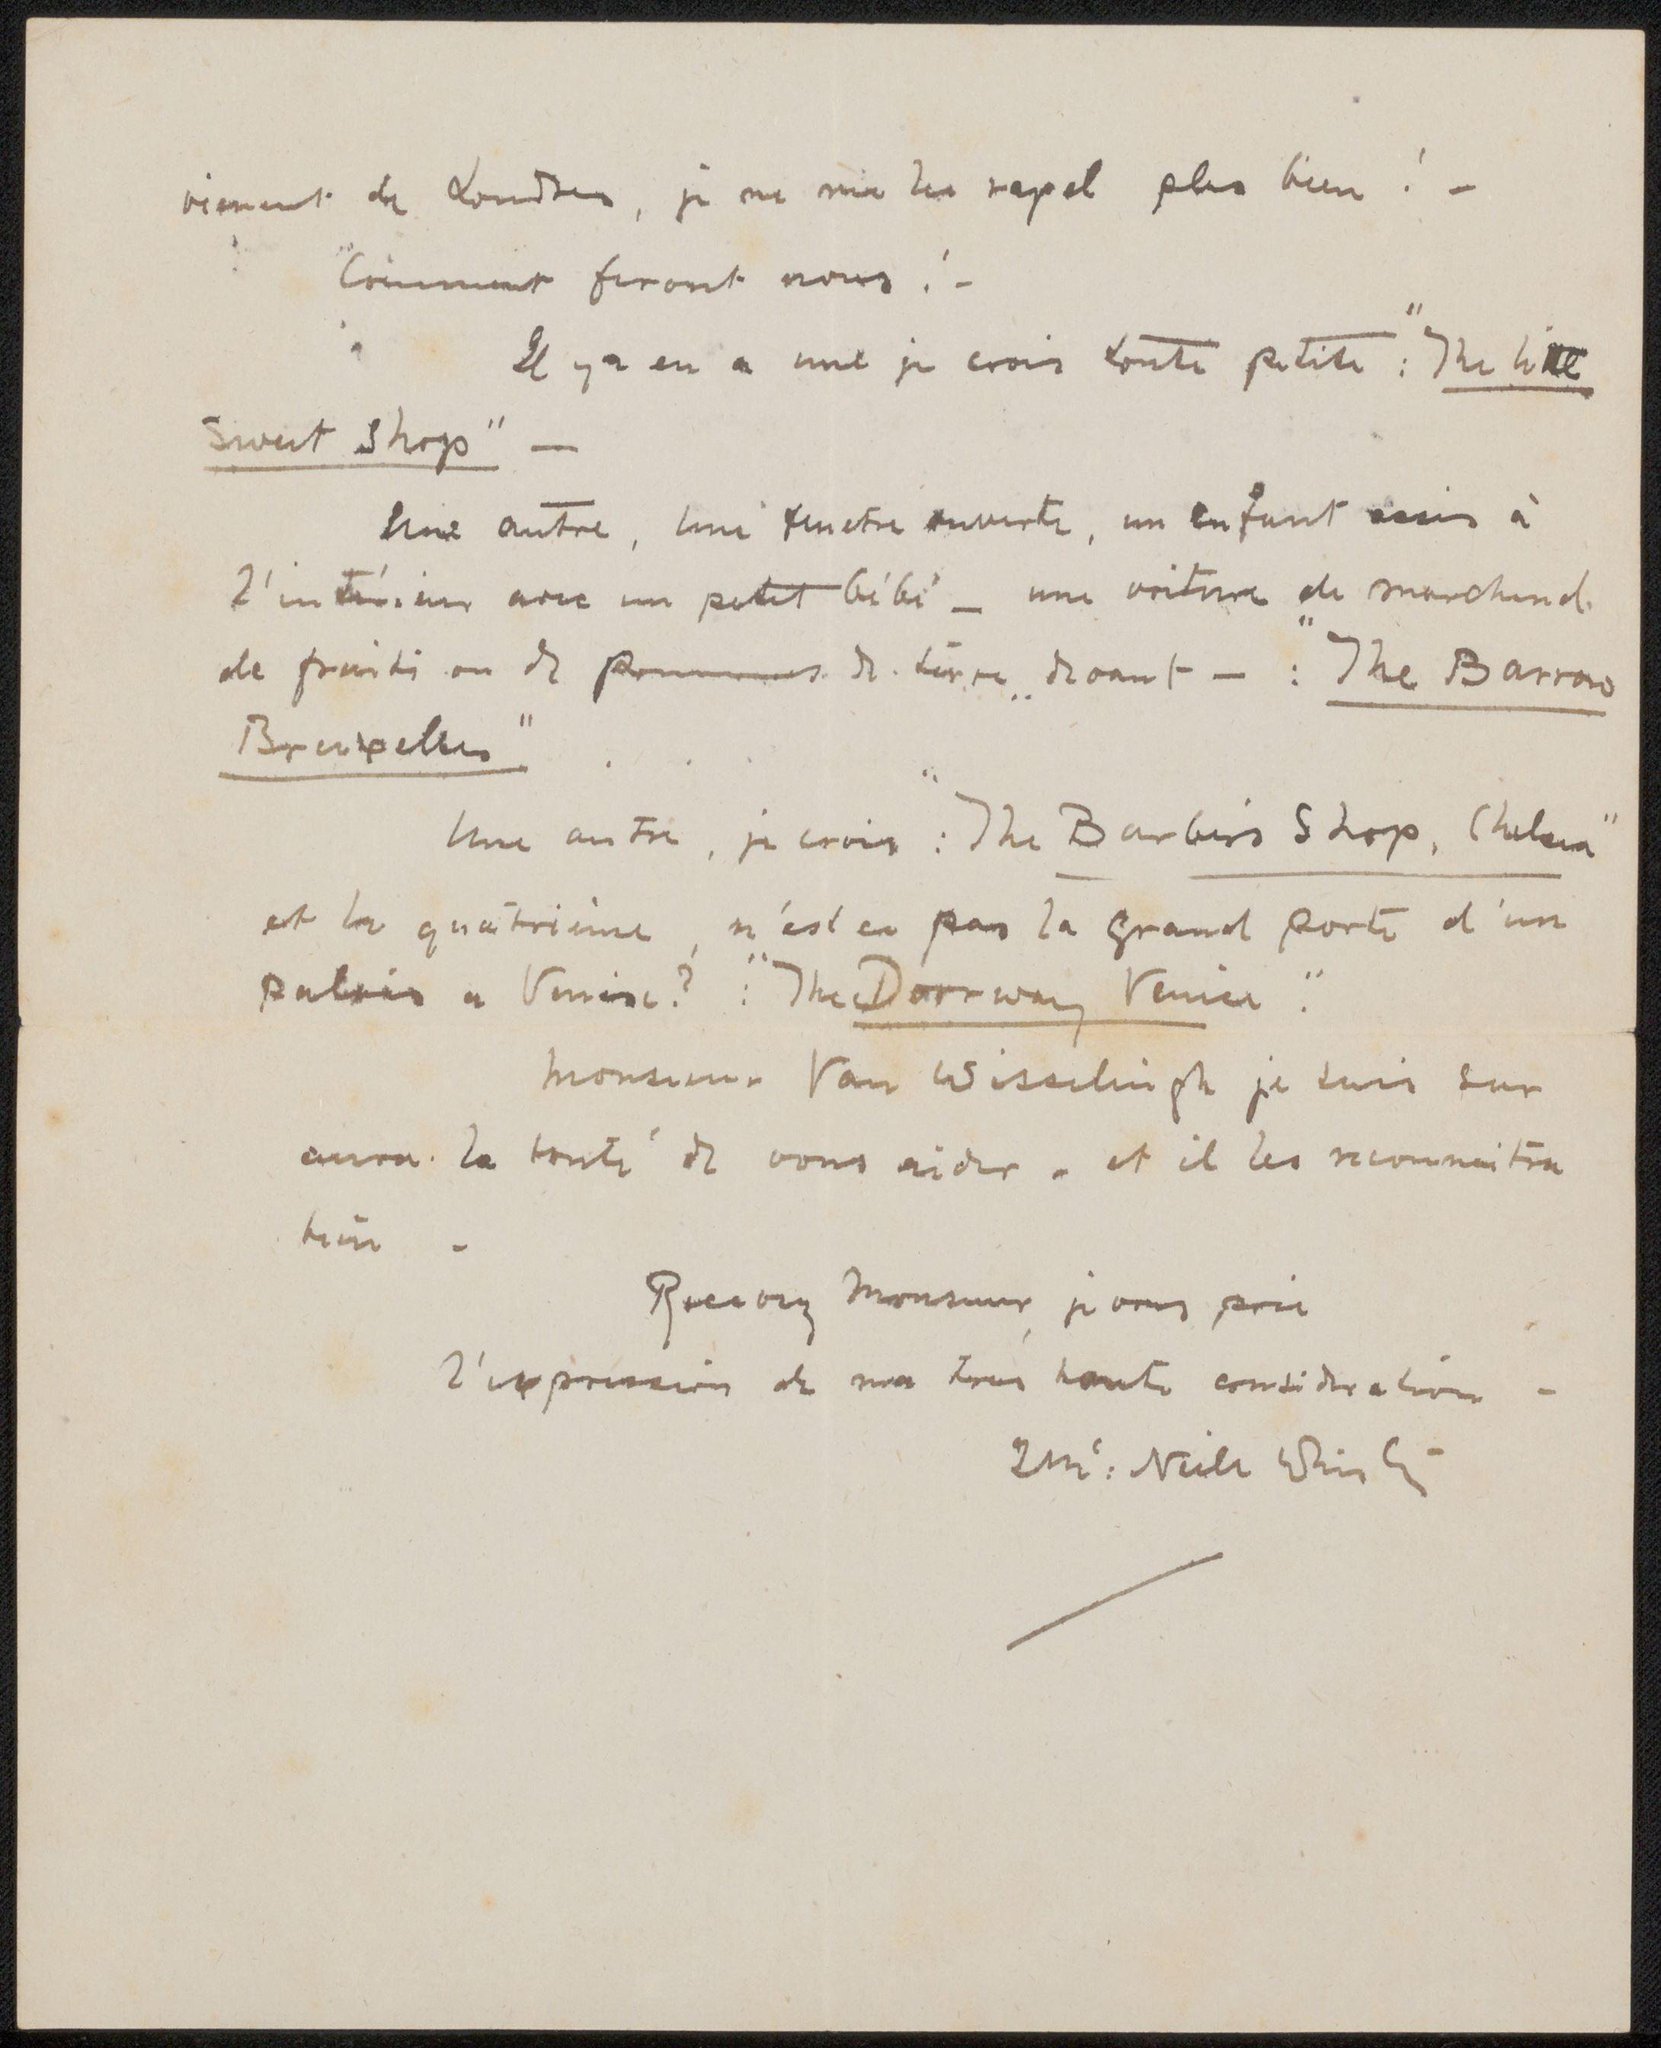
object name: letter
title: Brief aan Philip Zilcken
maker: james abbott mcneill whistler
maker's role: painter, print maker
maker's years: 1834-1903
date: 1867-1903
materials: ink, paper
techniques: pen, writing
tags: elbert jan van wisselingh, painter, draughtsman, philip zilcken, the graphic arts, exhibition ~ art, the hague, london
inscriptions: collector's mark: ‘RPK’